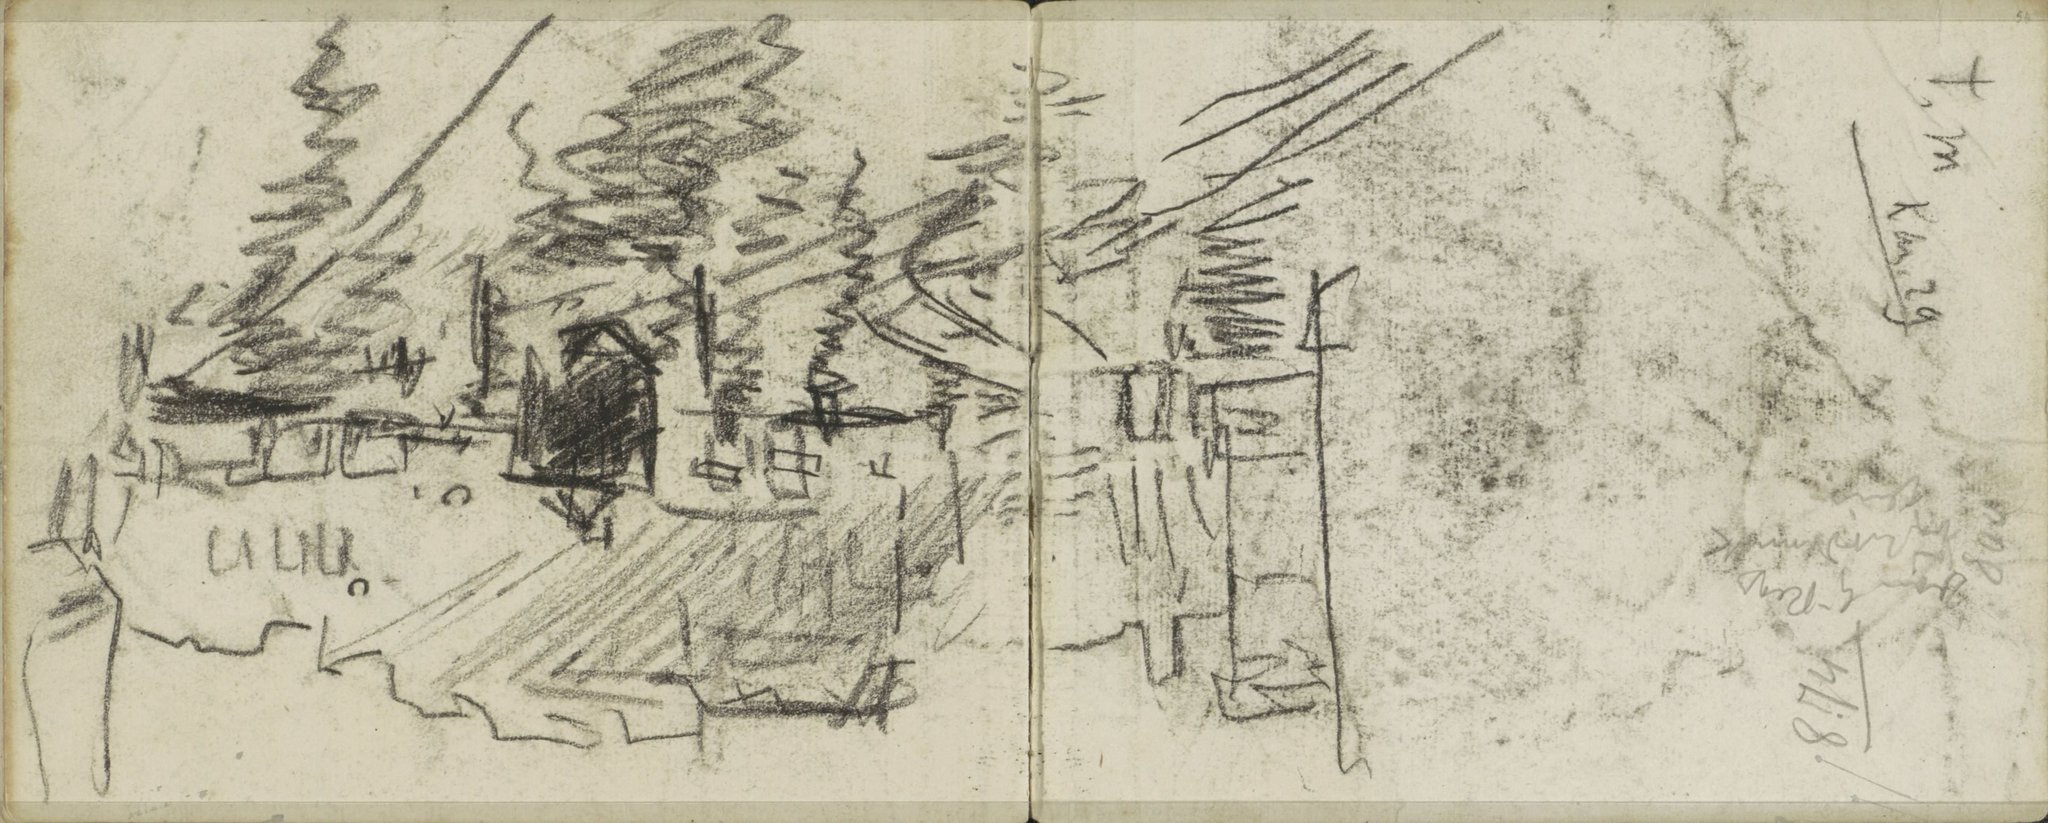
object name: sketchbook leaf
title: Gezicht op de Dam te Amsterdam met een rijtuig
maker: george hendrik breitner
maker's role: draughtsman, painter, print maker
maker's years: 1857-1923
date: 1886-1903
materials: chalk, paper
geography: amsterdam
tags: square, place, circus, etc., urban housing, four-wheeled, animal-drawn vehicle, e.g.: cab, carriage, coach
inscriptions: annotation: ‘[...]/ Dam bij regen/ [...]’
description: Pagina 55 en pagina 56, achterste schutblad, uit een schetsboek met 27 bladen.